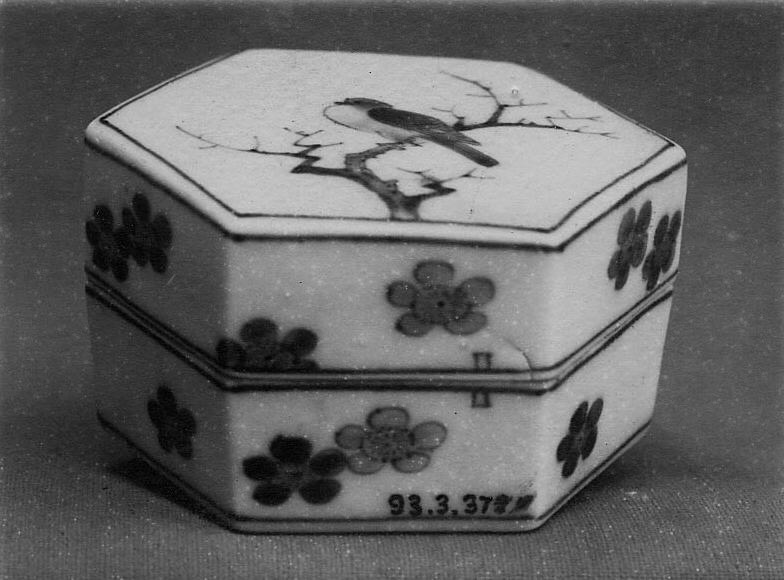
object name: incense box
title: Incense Box with Cover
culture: japanese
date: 1820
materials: glaze, porcelain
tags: birds,flowers